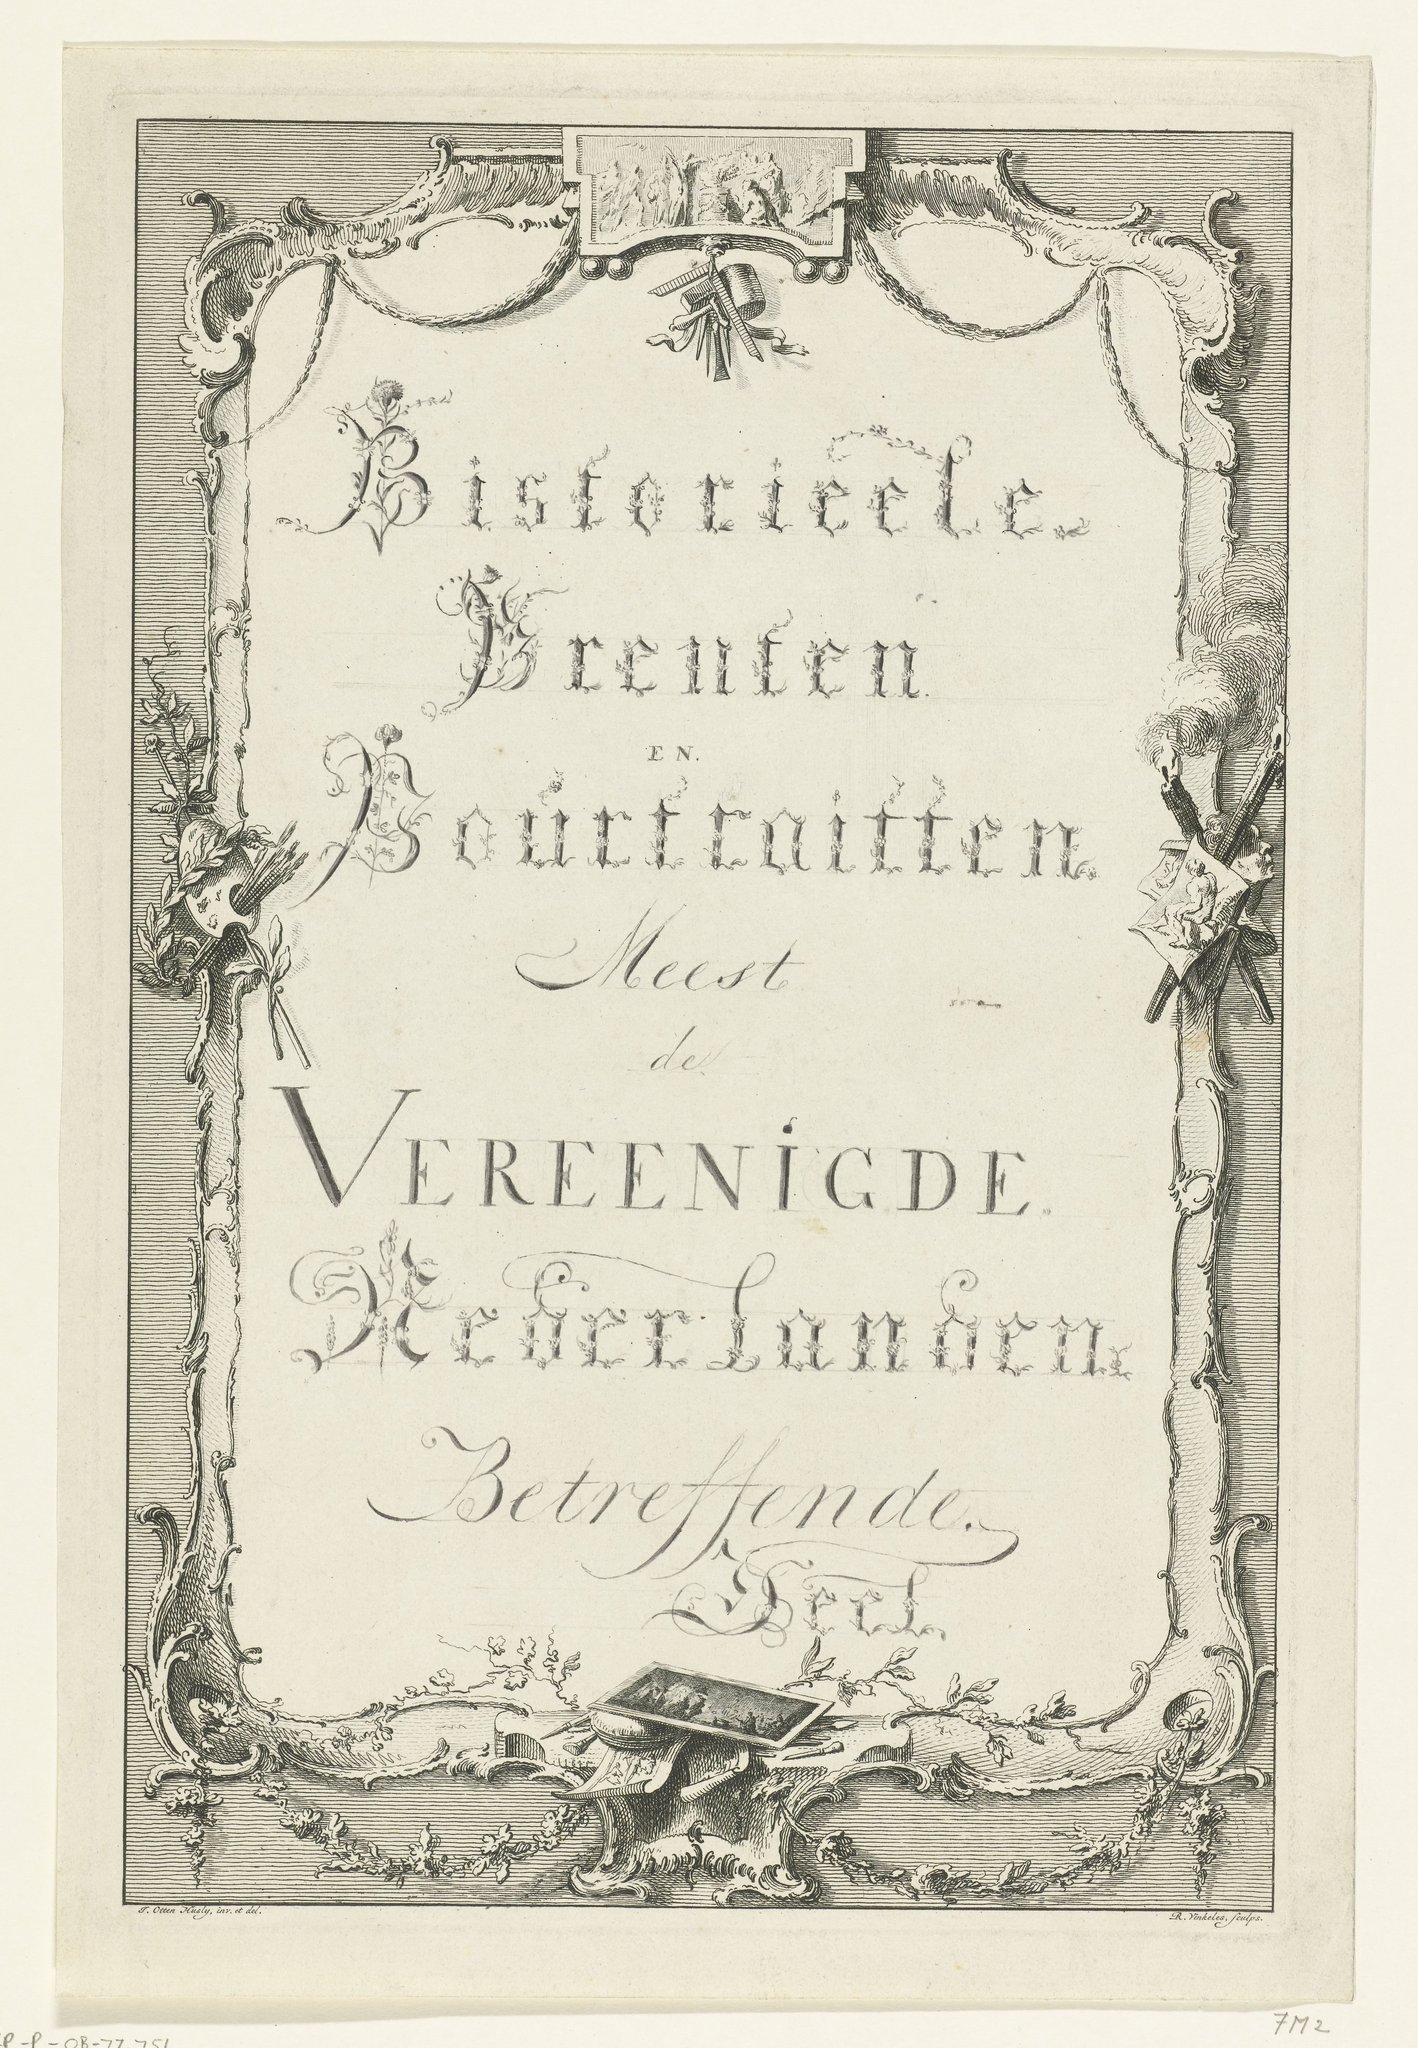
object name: print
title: Historieele Prenten en Pourtraitten. Meest de Vereenigde Nederlanden Betreffende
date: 1760-1770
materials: ink, paper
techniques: etching, pen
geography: netherlands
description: Titelprent voor een platenatlas of verzamling van historieplaten. Binnen een gedrukte cartouche een geschreven opschrift: Historieele Prenten en Pourtraitten Meest de Vereenigde Nederlanden Betreffende. Deel.